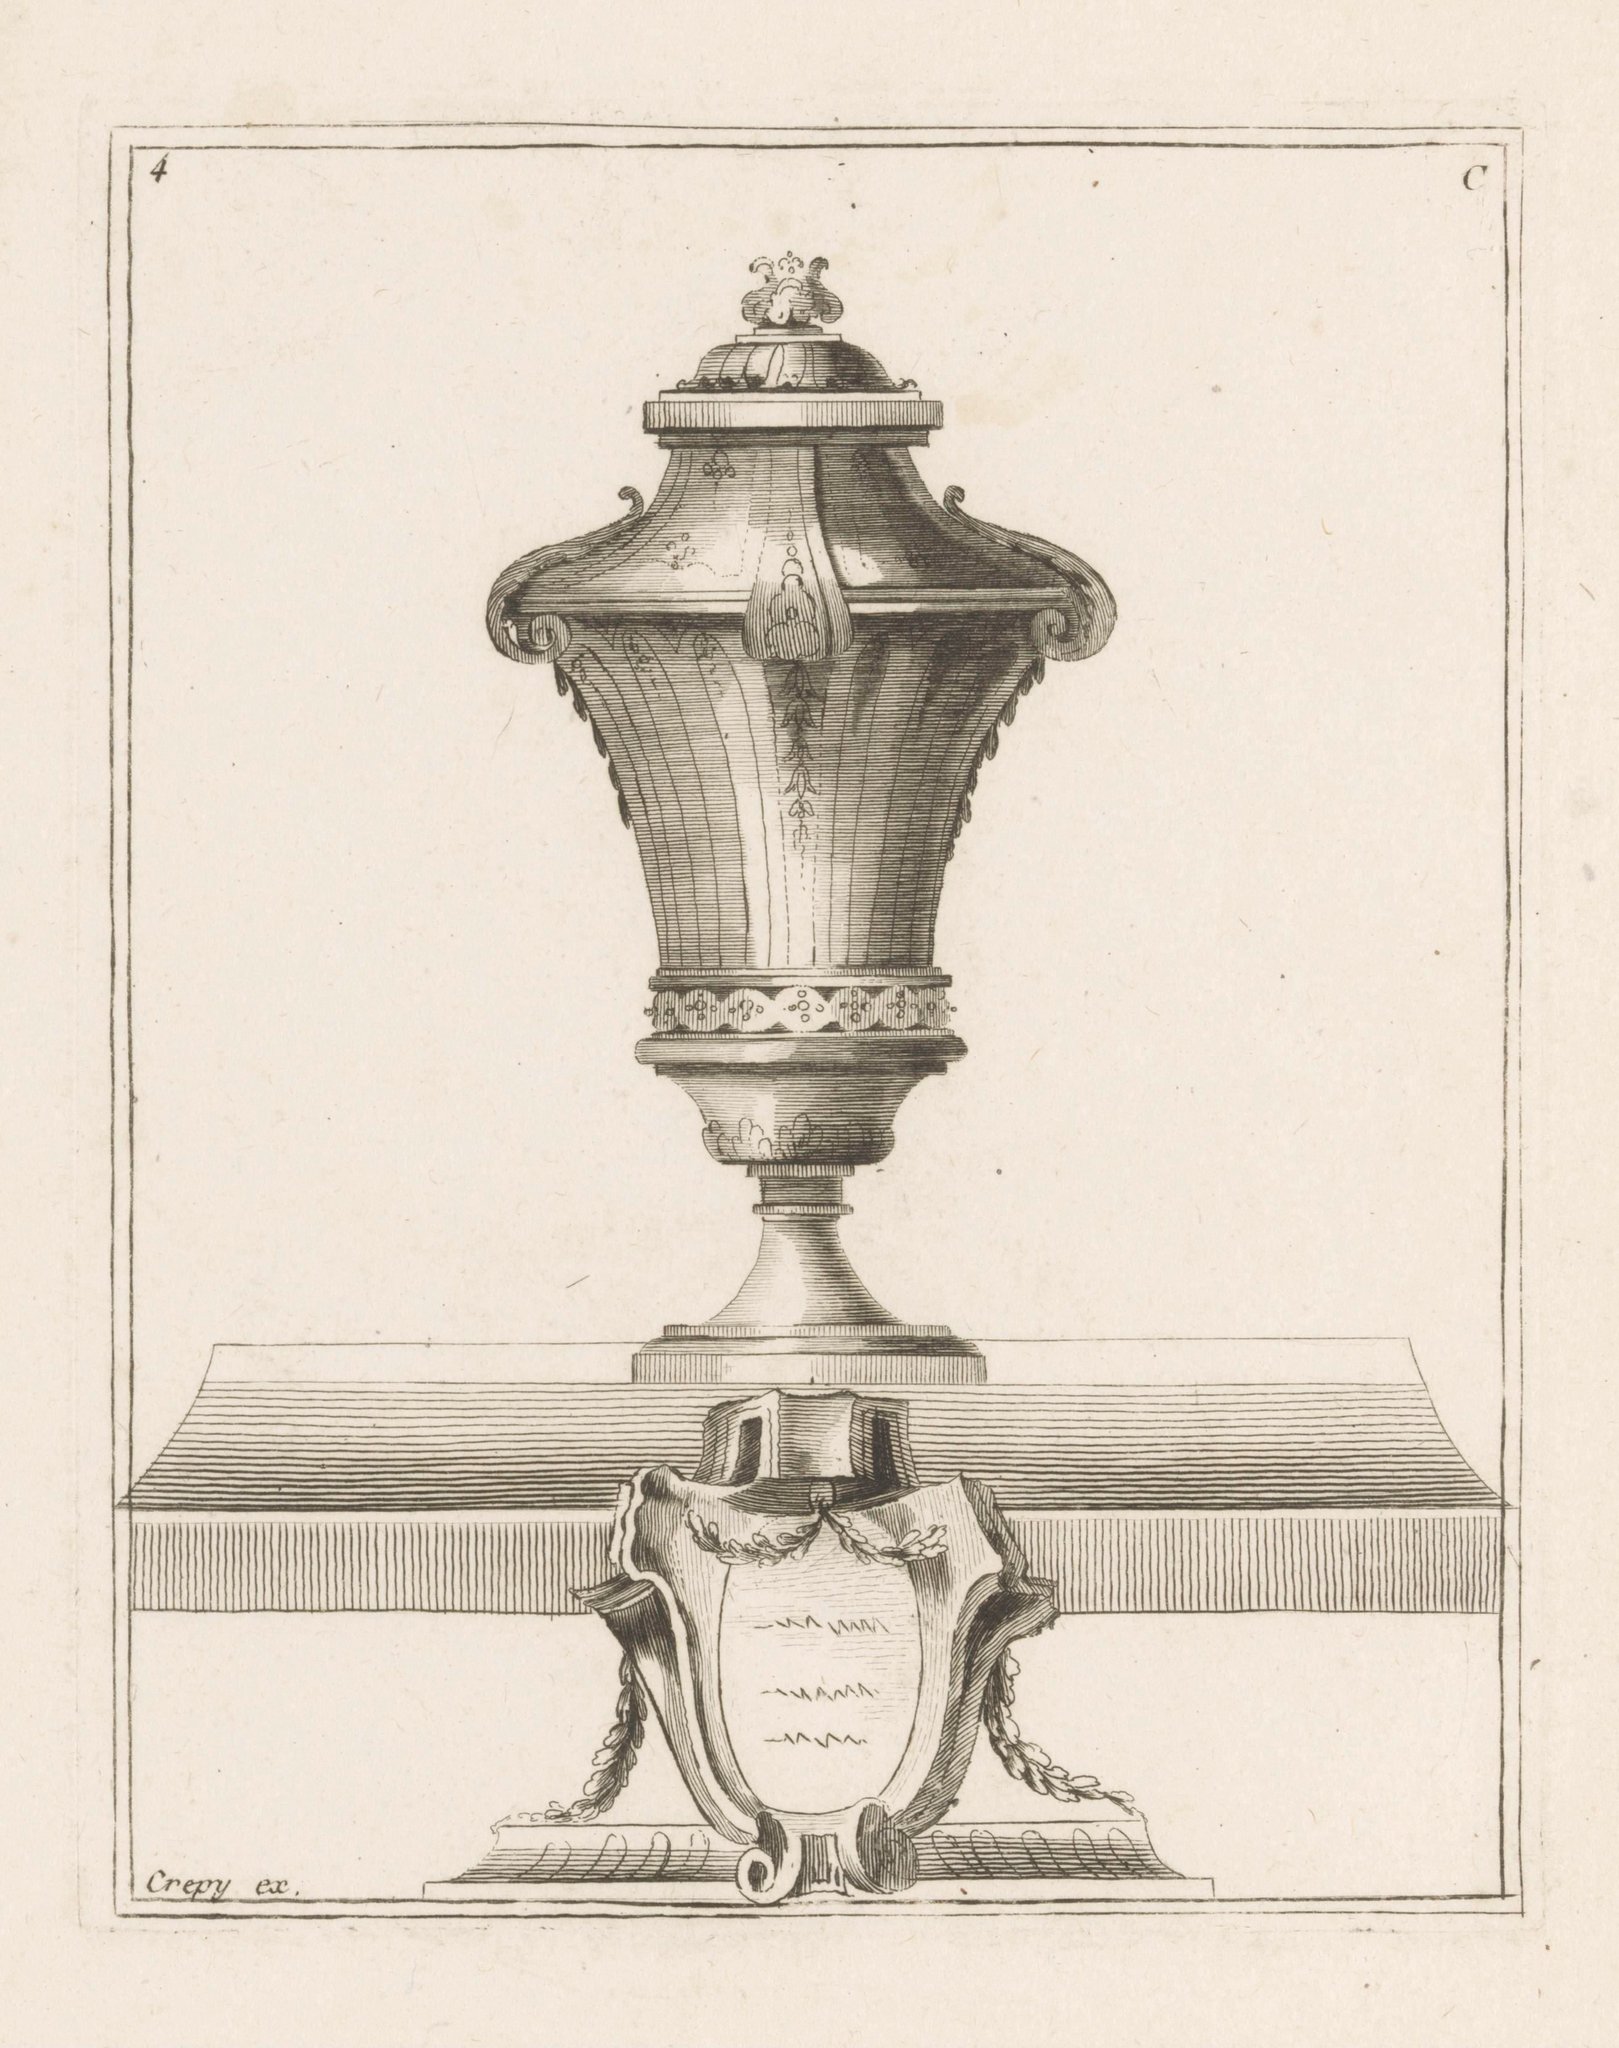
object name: print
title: C Nouveau Livre De Vases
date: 1770-1780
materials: paper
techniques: etching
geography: paris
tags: vase ~ ornament, ornament ~ cartouche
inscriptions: collector's mark: Lugt 2760, collector's mark: Lugt 2228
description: Een geornamenteerde vaas, daaronder een cartouche met guirlande.